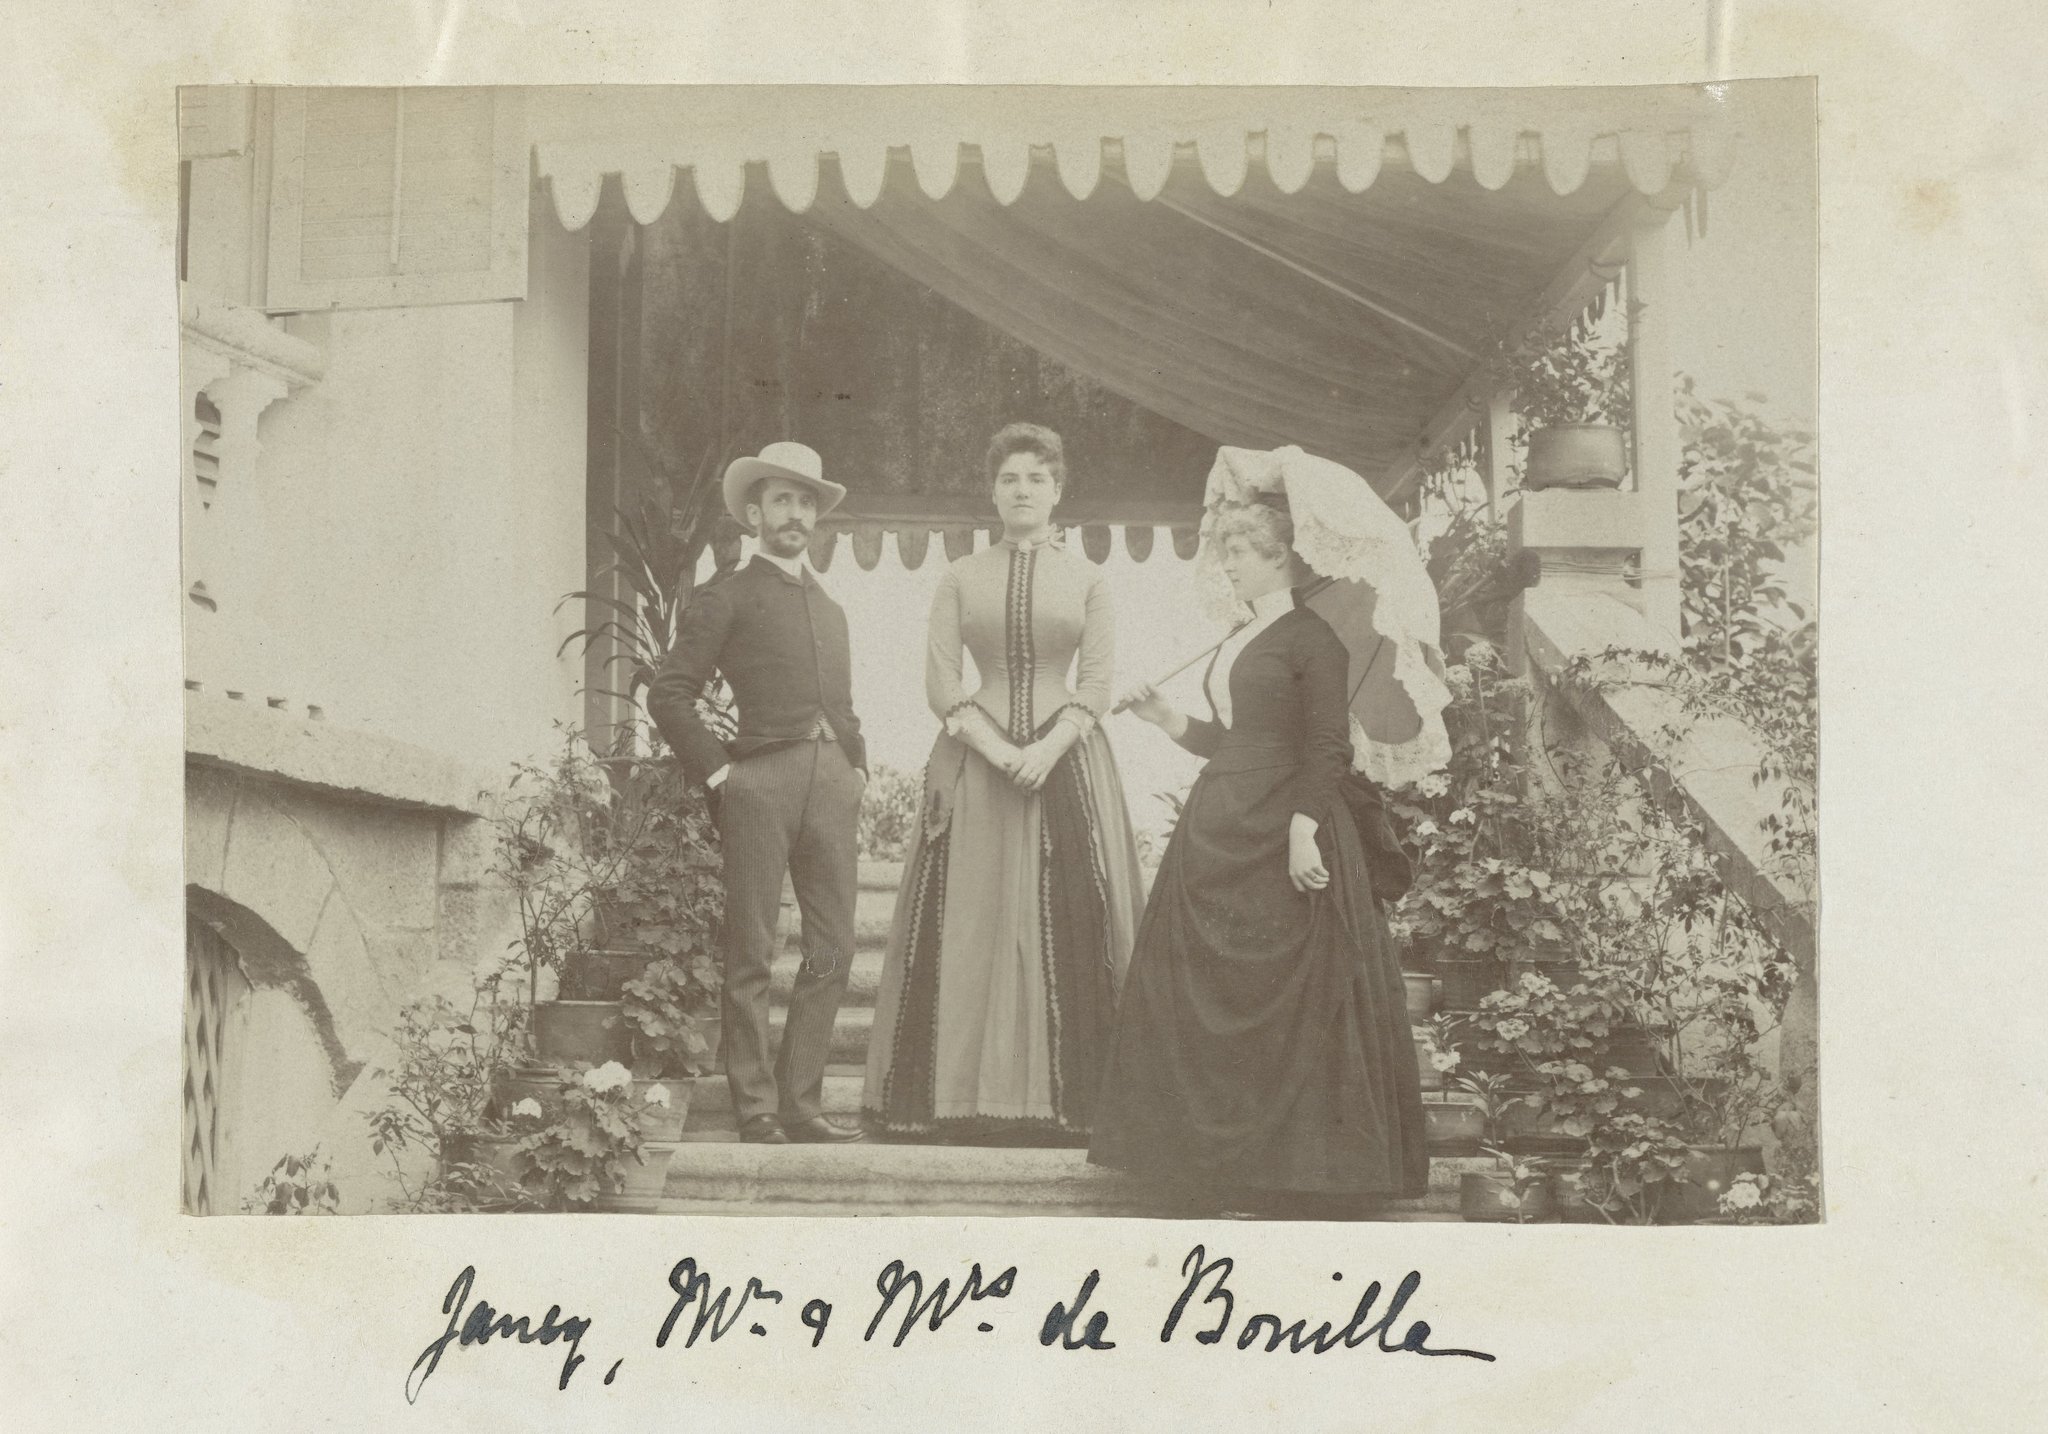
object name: photograph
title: Portret van twee vrouwen en een man, aangeduid als Janey en Mr en Mrs de Bouille, op een trap voor een huis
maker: Anonymous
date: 1879-1890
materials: paper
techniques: albumen print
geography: china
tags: historical persons not known by name - bb - woman, front steps, parasol, sunshade, historical persons not known by name, china